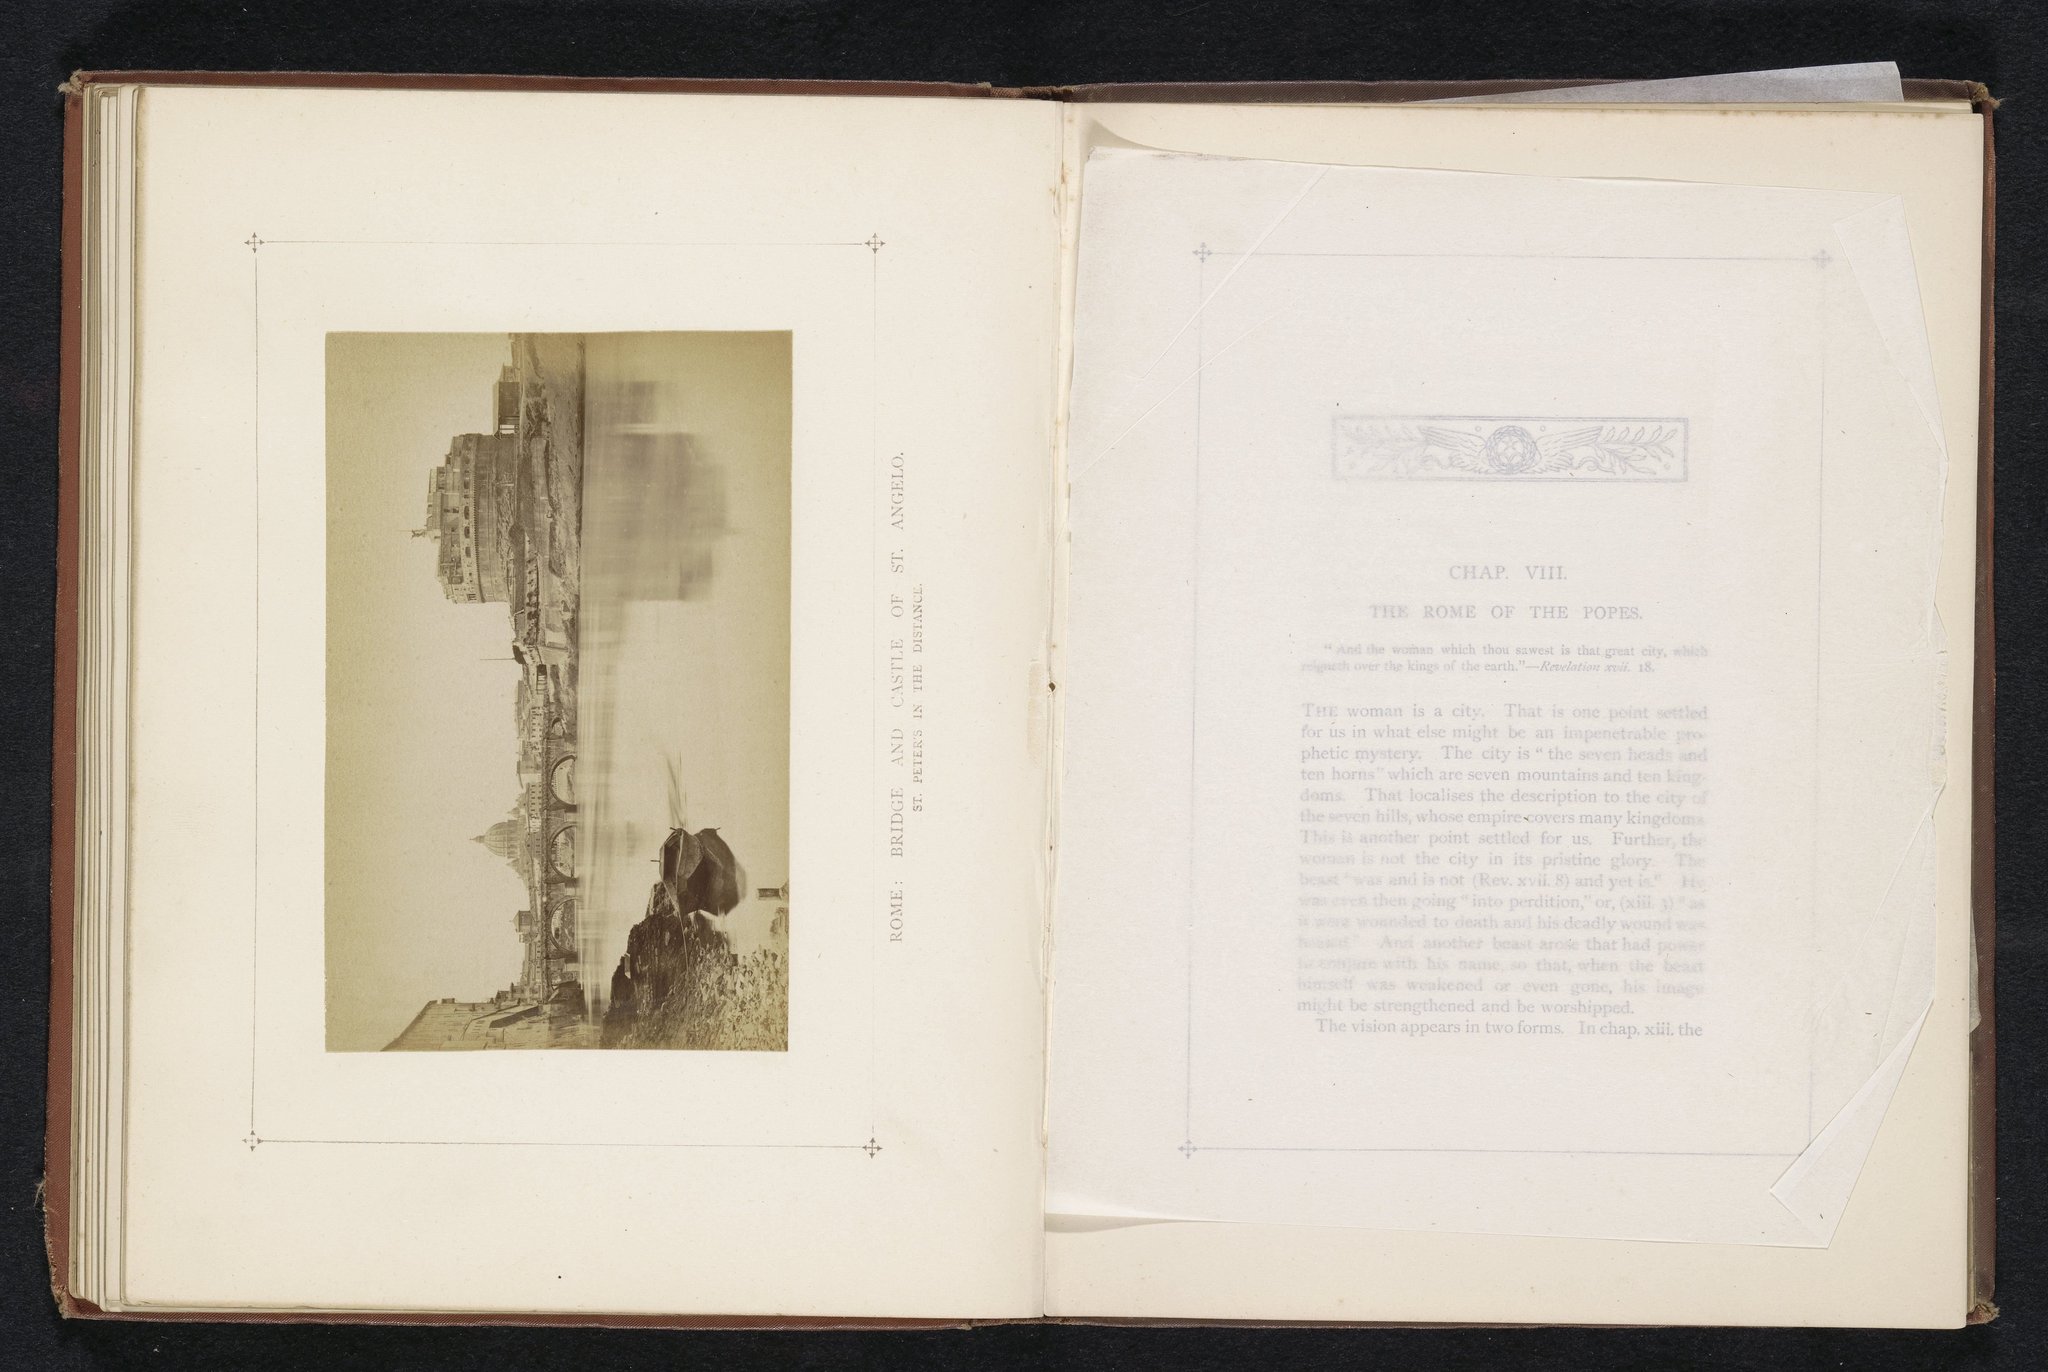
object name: photograph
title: Rome: Bridge and castle of St. Angelo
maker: Anonymous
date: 1872-1882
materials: photographic support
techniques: albumen print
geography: rome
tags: fortress, bridge